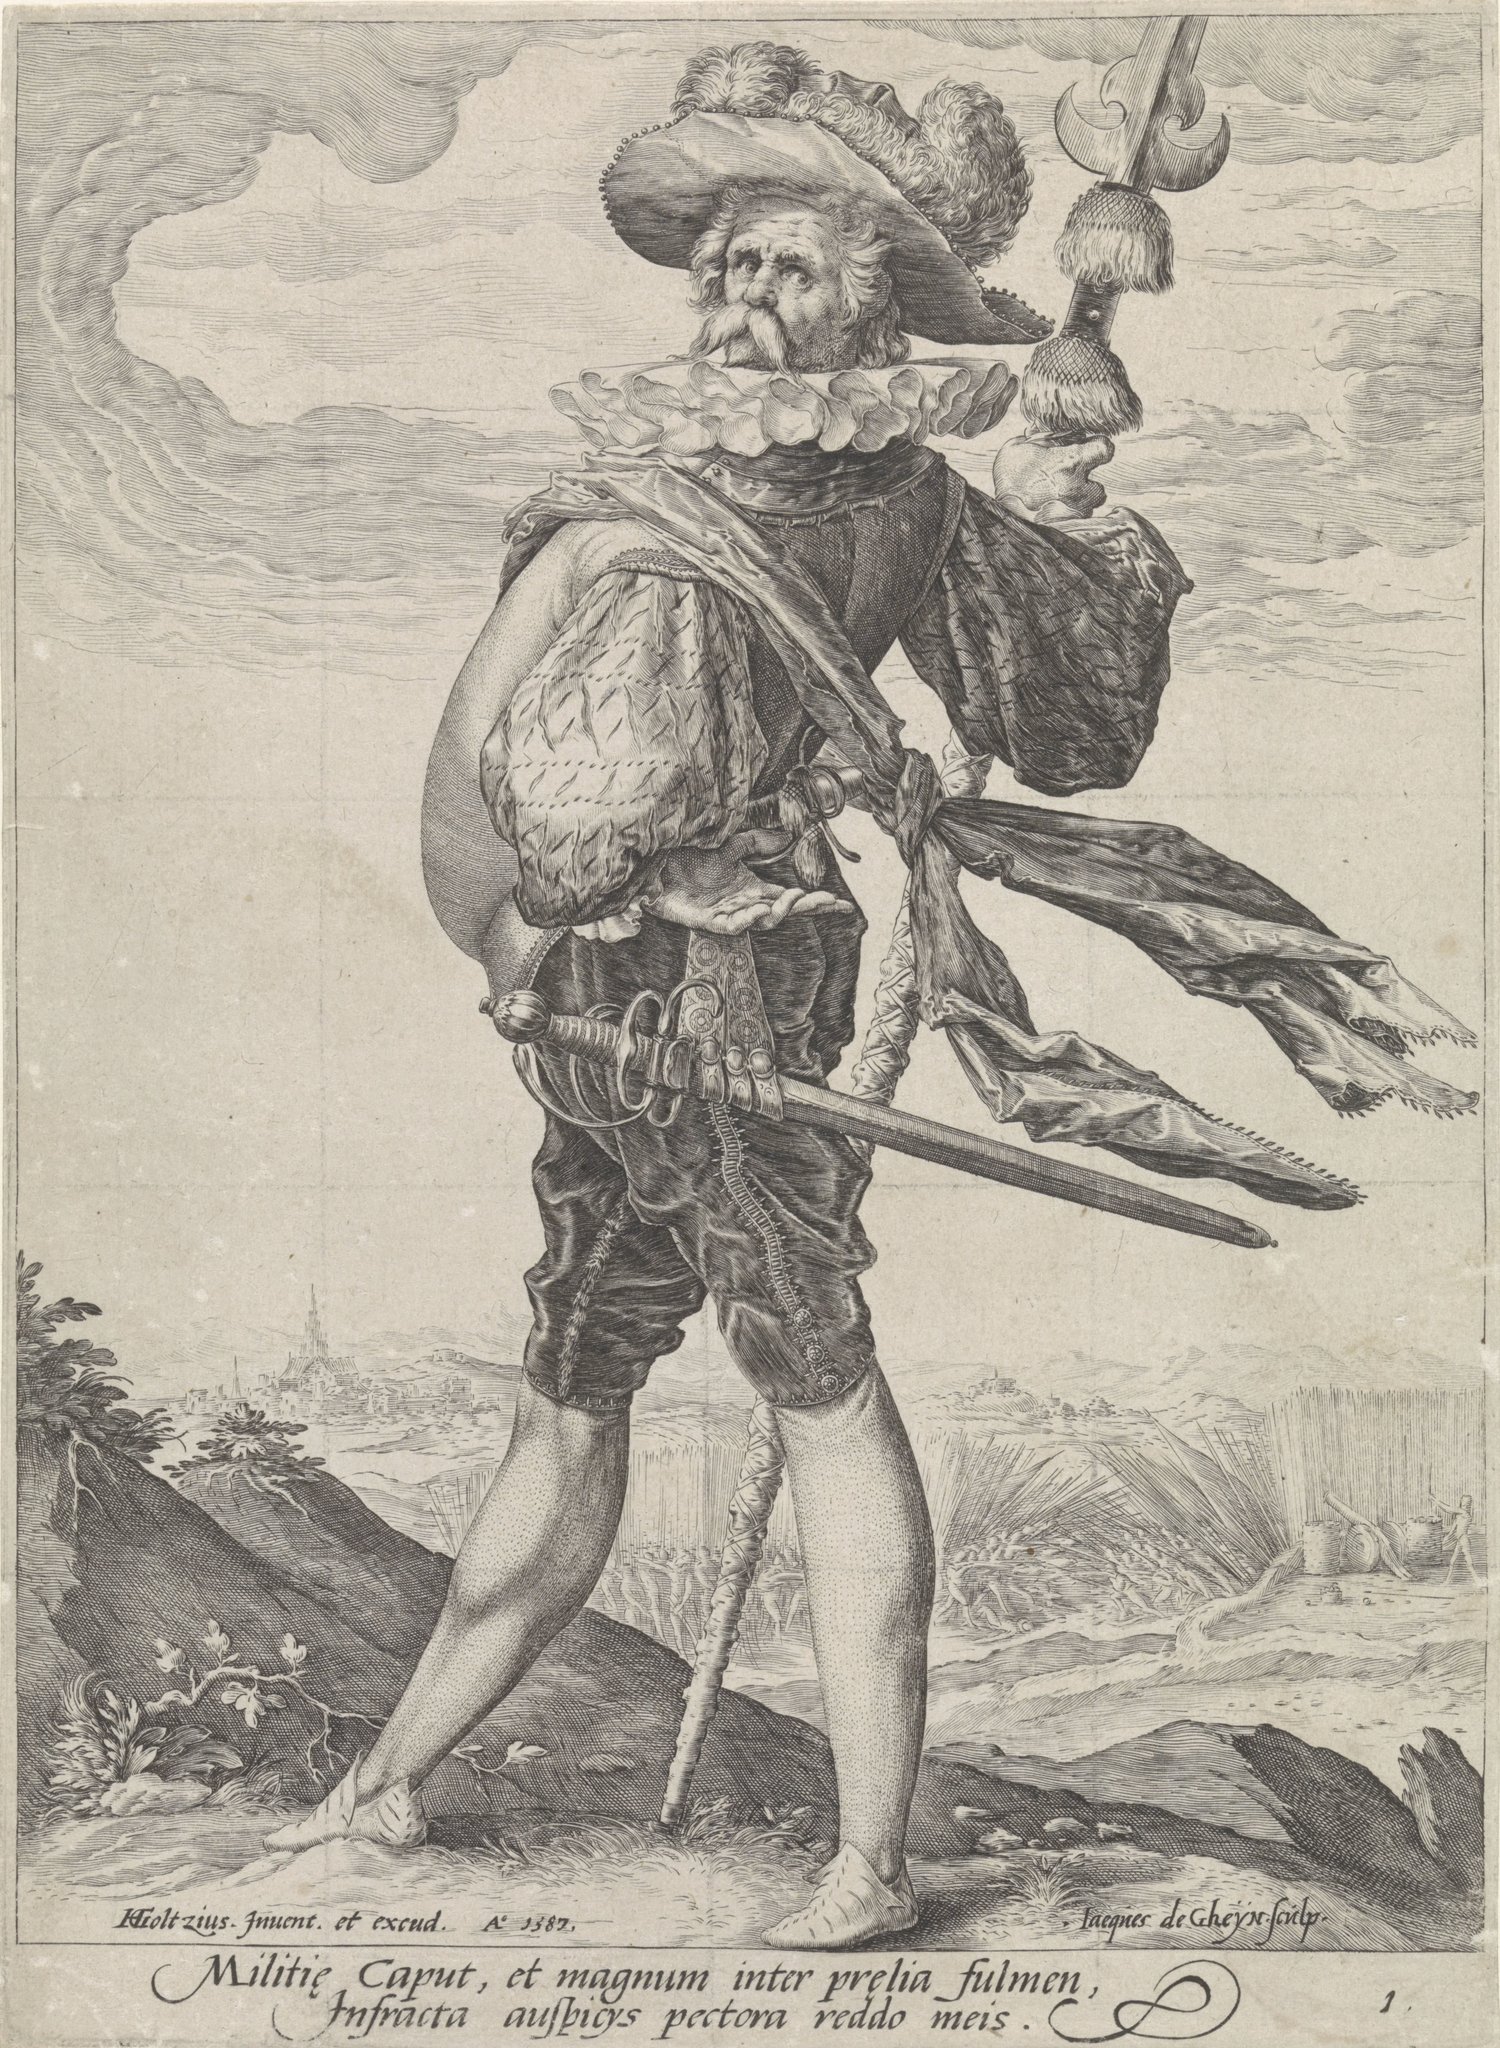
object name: print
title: Officieren en soldaten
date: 1587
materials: paper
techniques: engraving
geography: netherlands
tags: helved weapons, polearms (for striking, hacking, thrusting), battle, officer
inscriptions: collector's mark: Lugt 240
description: Een man in militaire uitdossing (een kolonel), ten voeten uit, op de linkerzijde gezien, een zwaard aan zijn gordel, een stokwapen (partizaan) in zijn rechterhand. Op de achtergrond een heuvelachtig landschap waarin een slag plaatsvindt. Onder de voorstelling twee regels tekst in Latijn. Deze prent is onderdeel van een serie van 12 genummerde prenten van militairen, ten voeten uit weergegeven tegen een landschappelijke achtergrond waarin krijgshandelingen verricht worden, en met een tweeregelig Latijns onderschrift.